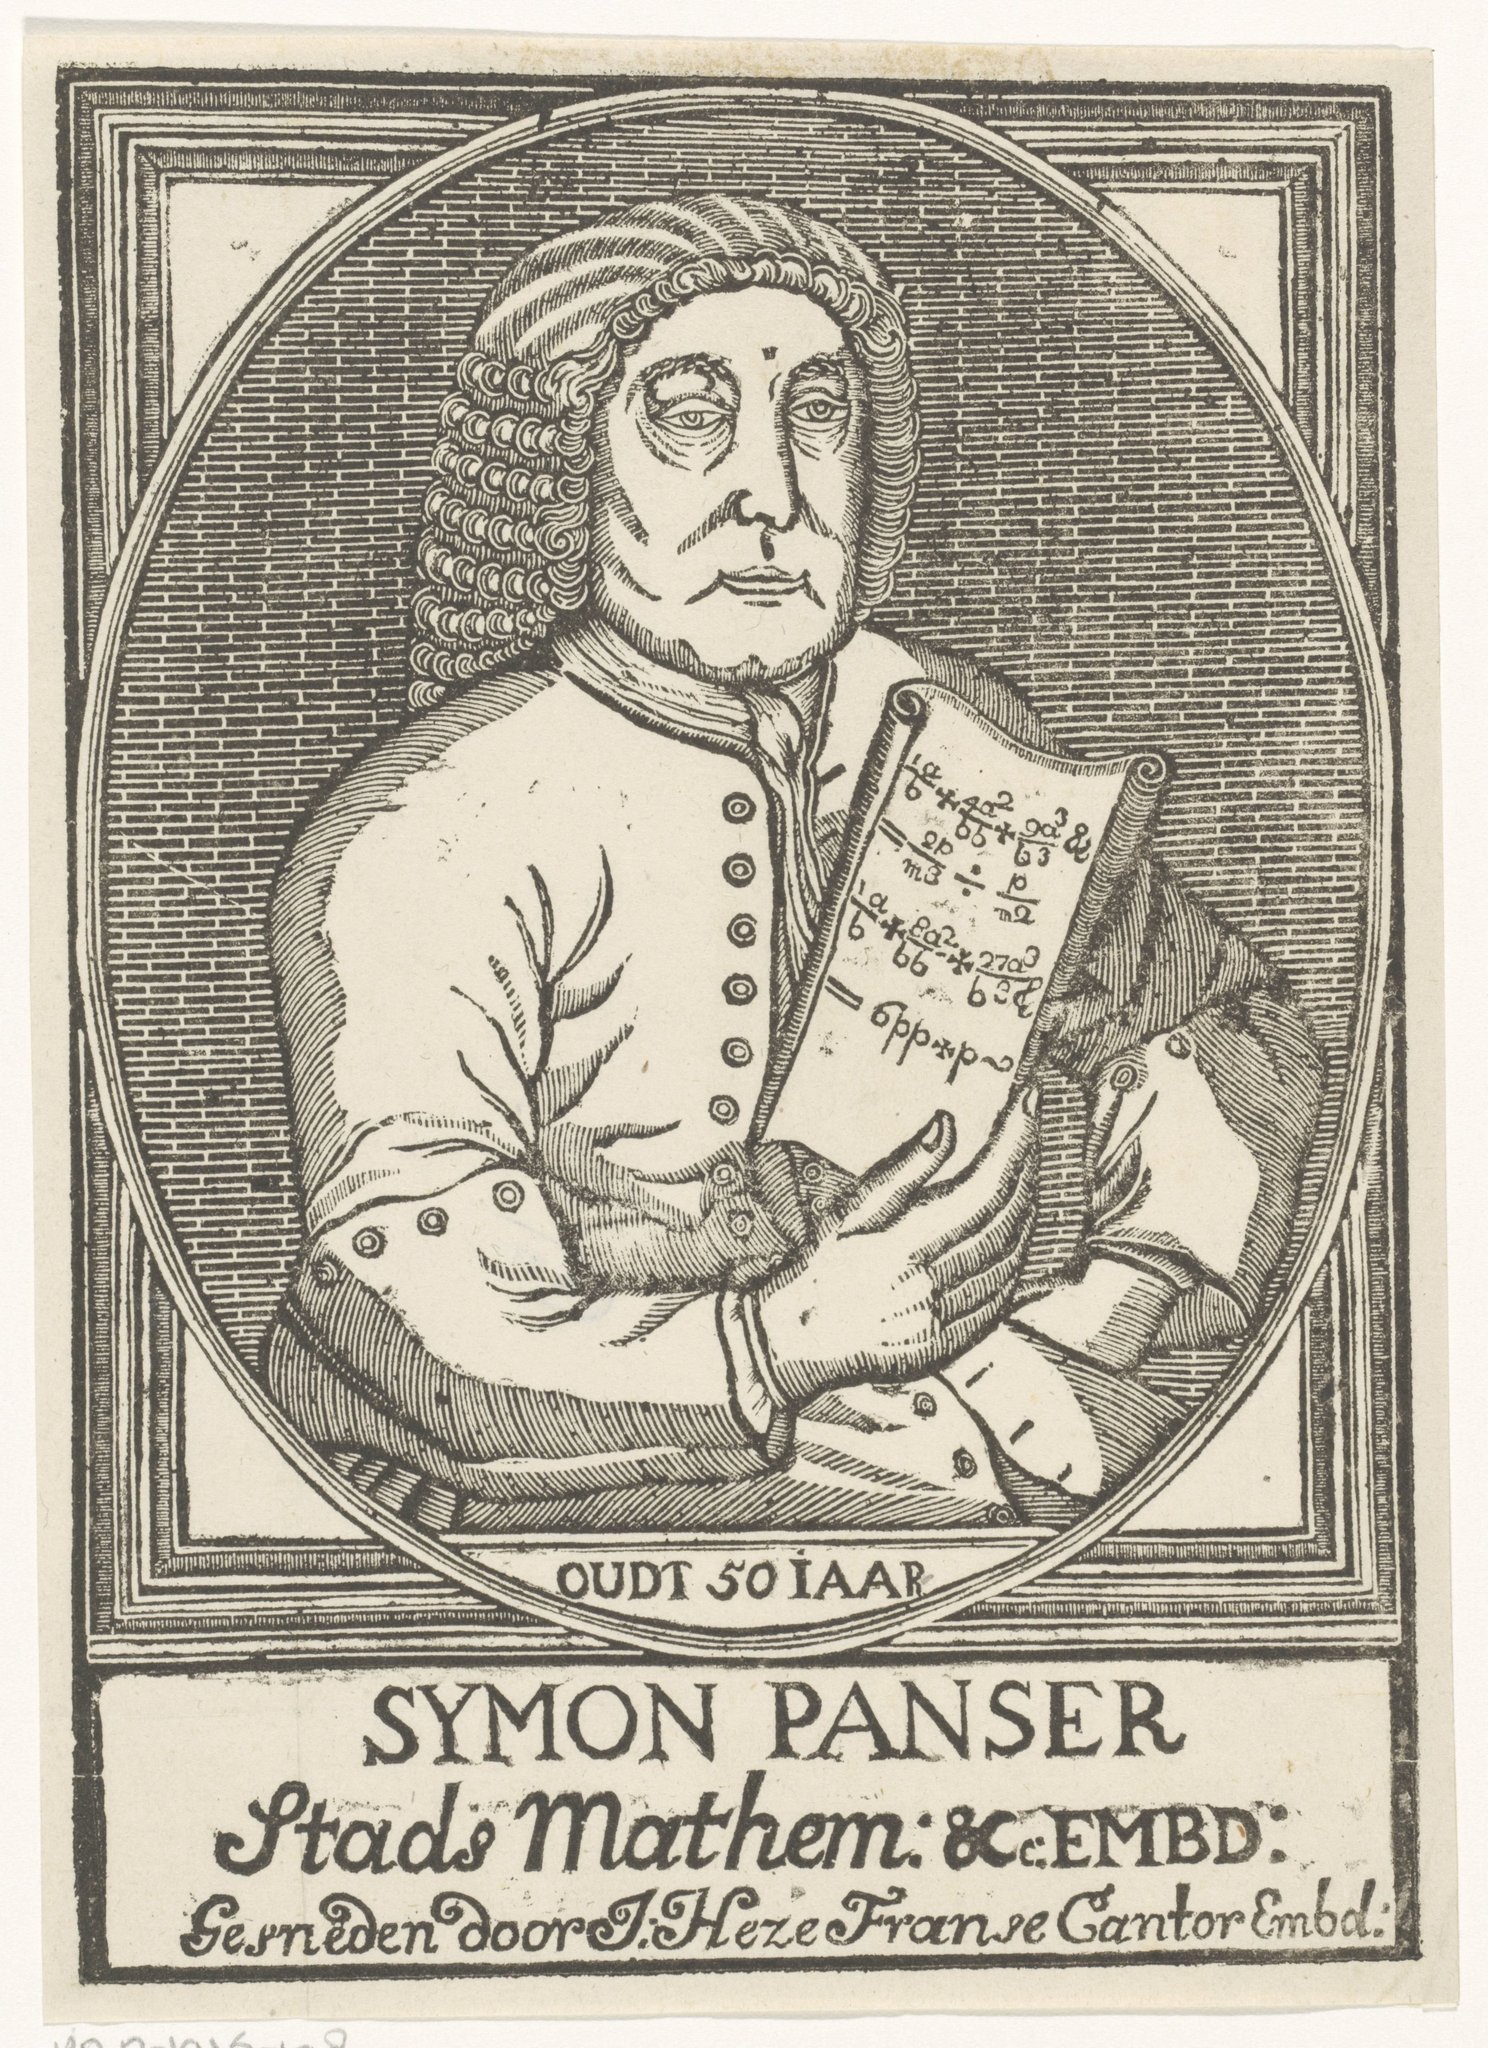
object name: print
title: Portret van Simon Jansz. Panser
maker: j. heze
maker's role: print maker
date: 1700-1799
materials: paper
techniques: woodcut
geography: netherlands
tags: simon jansz. panser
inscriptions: collector's mark: Lugt 2228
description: Portret van Simon Jansz. Panser in een ovaal met een balustrade met zijn leeftijd. In een kader zijn naam en beroep.